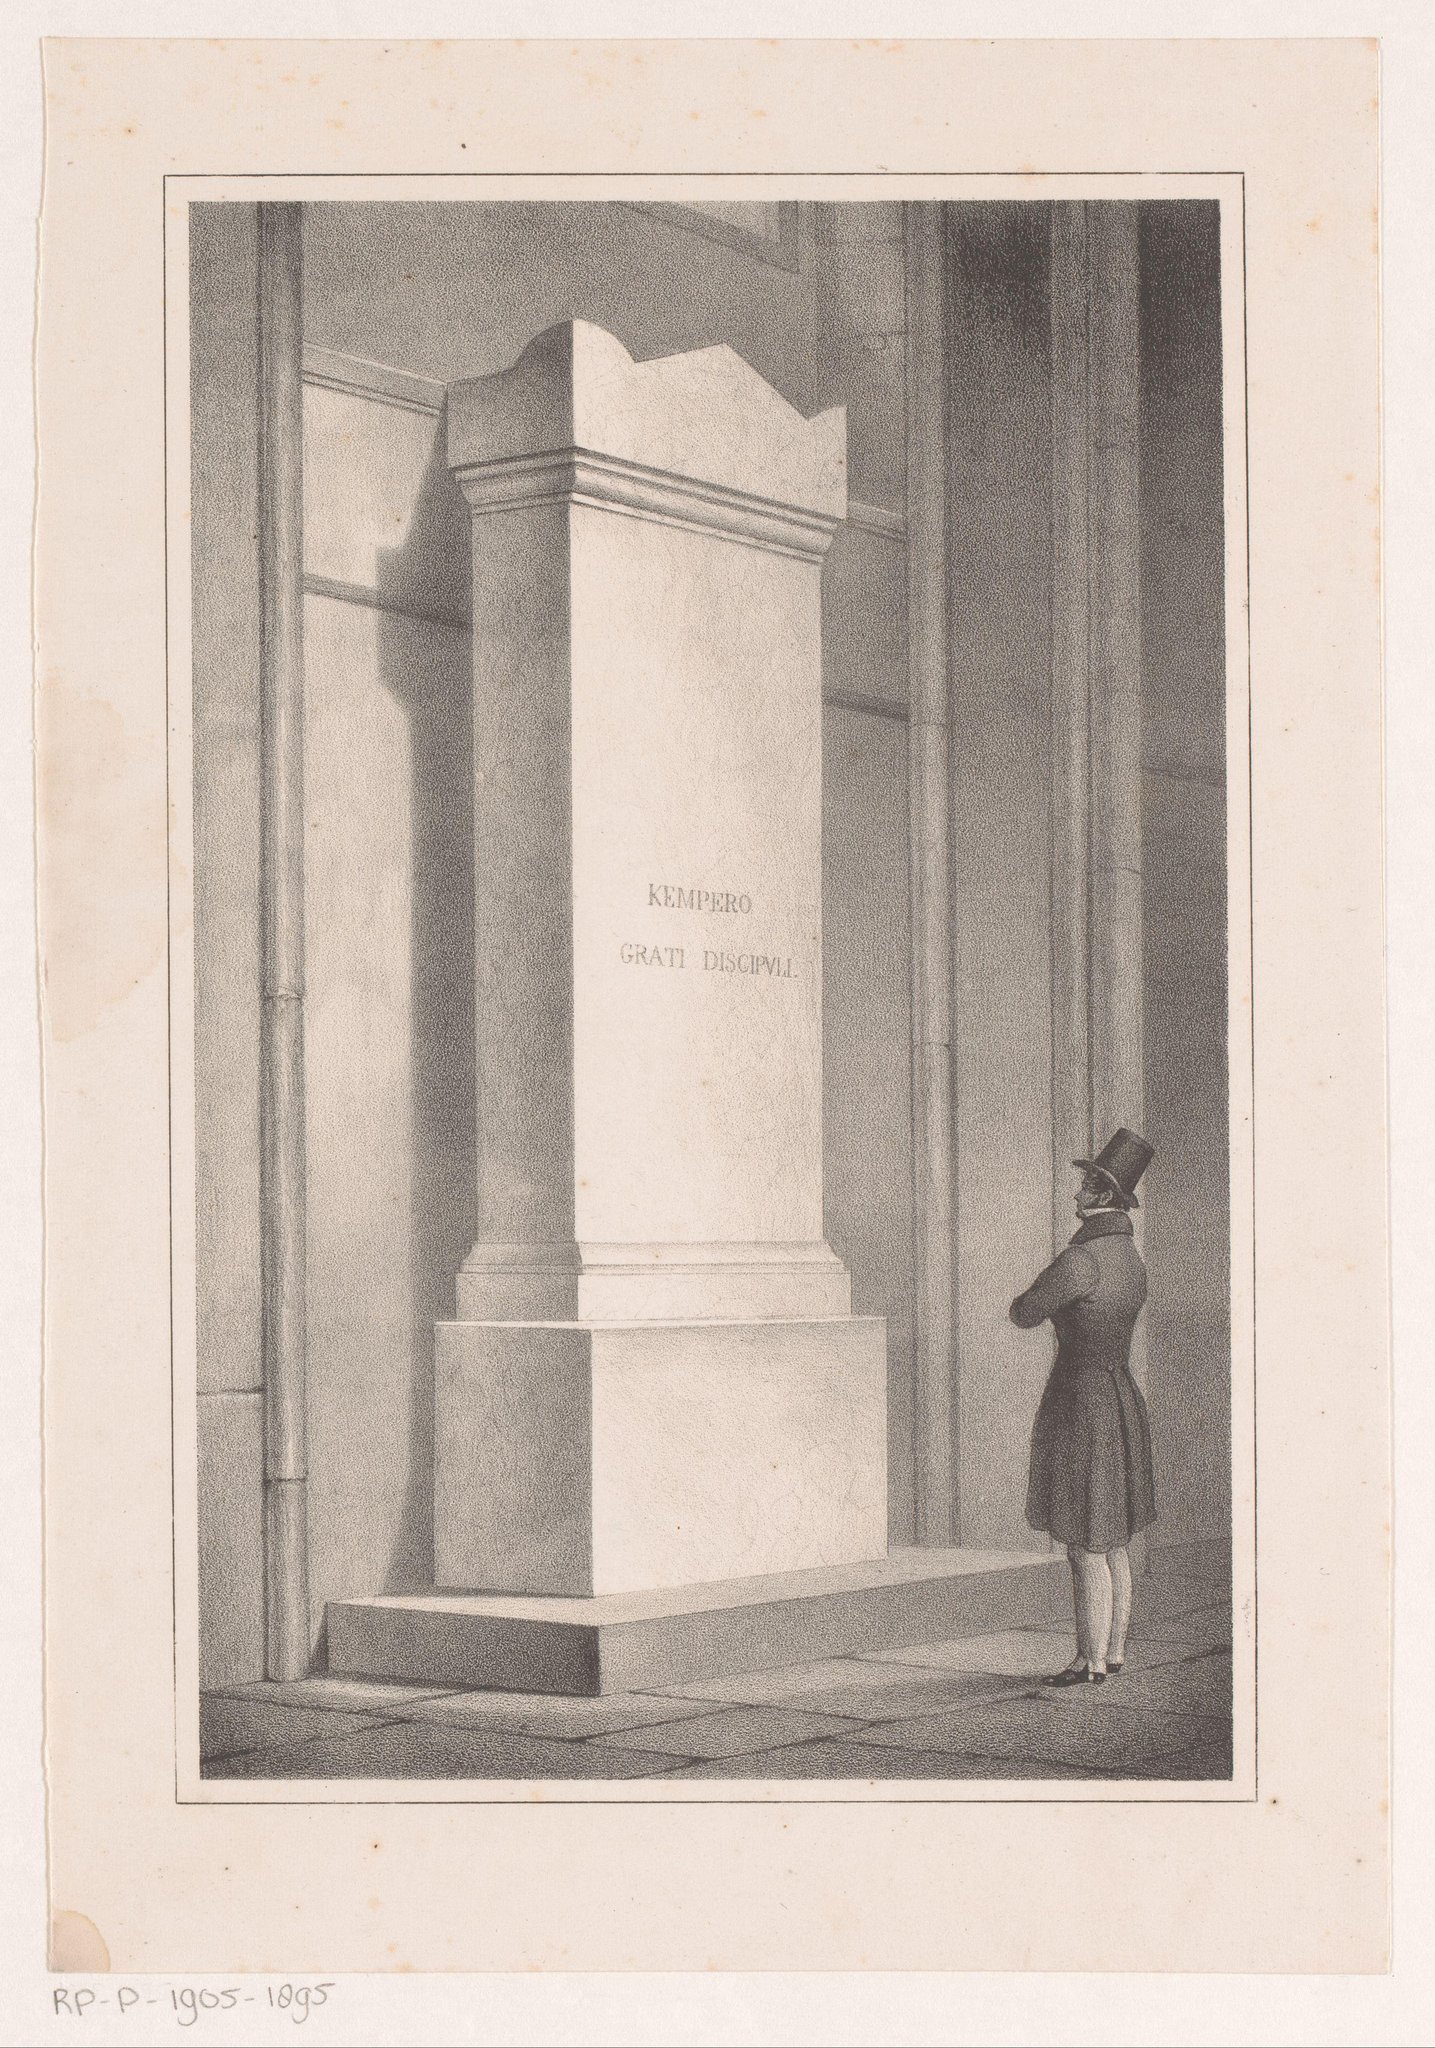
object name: print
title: Man staat voor grafmonument van Joan Melchior Kemper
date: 1835-1871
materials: paper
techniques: lithograph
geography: leiden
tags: amsterdam, leiden, jonkheer joan melchior kemper, grave, tomb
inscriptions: collector's mark: Lugt 2228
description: Een man met hoge hoed staat in Pieterskerk te Leiden voor het grafmonument van Joan Melchior Kemper, ingewijd in 1835.